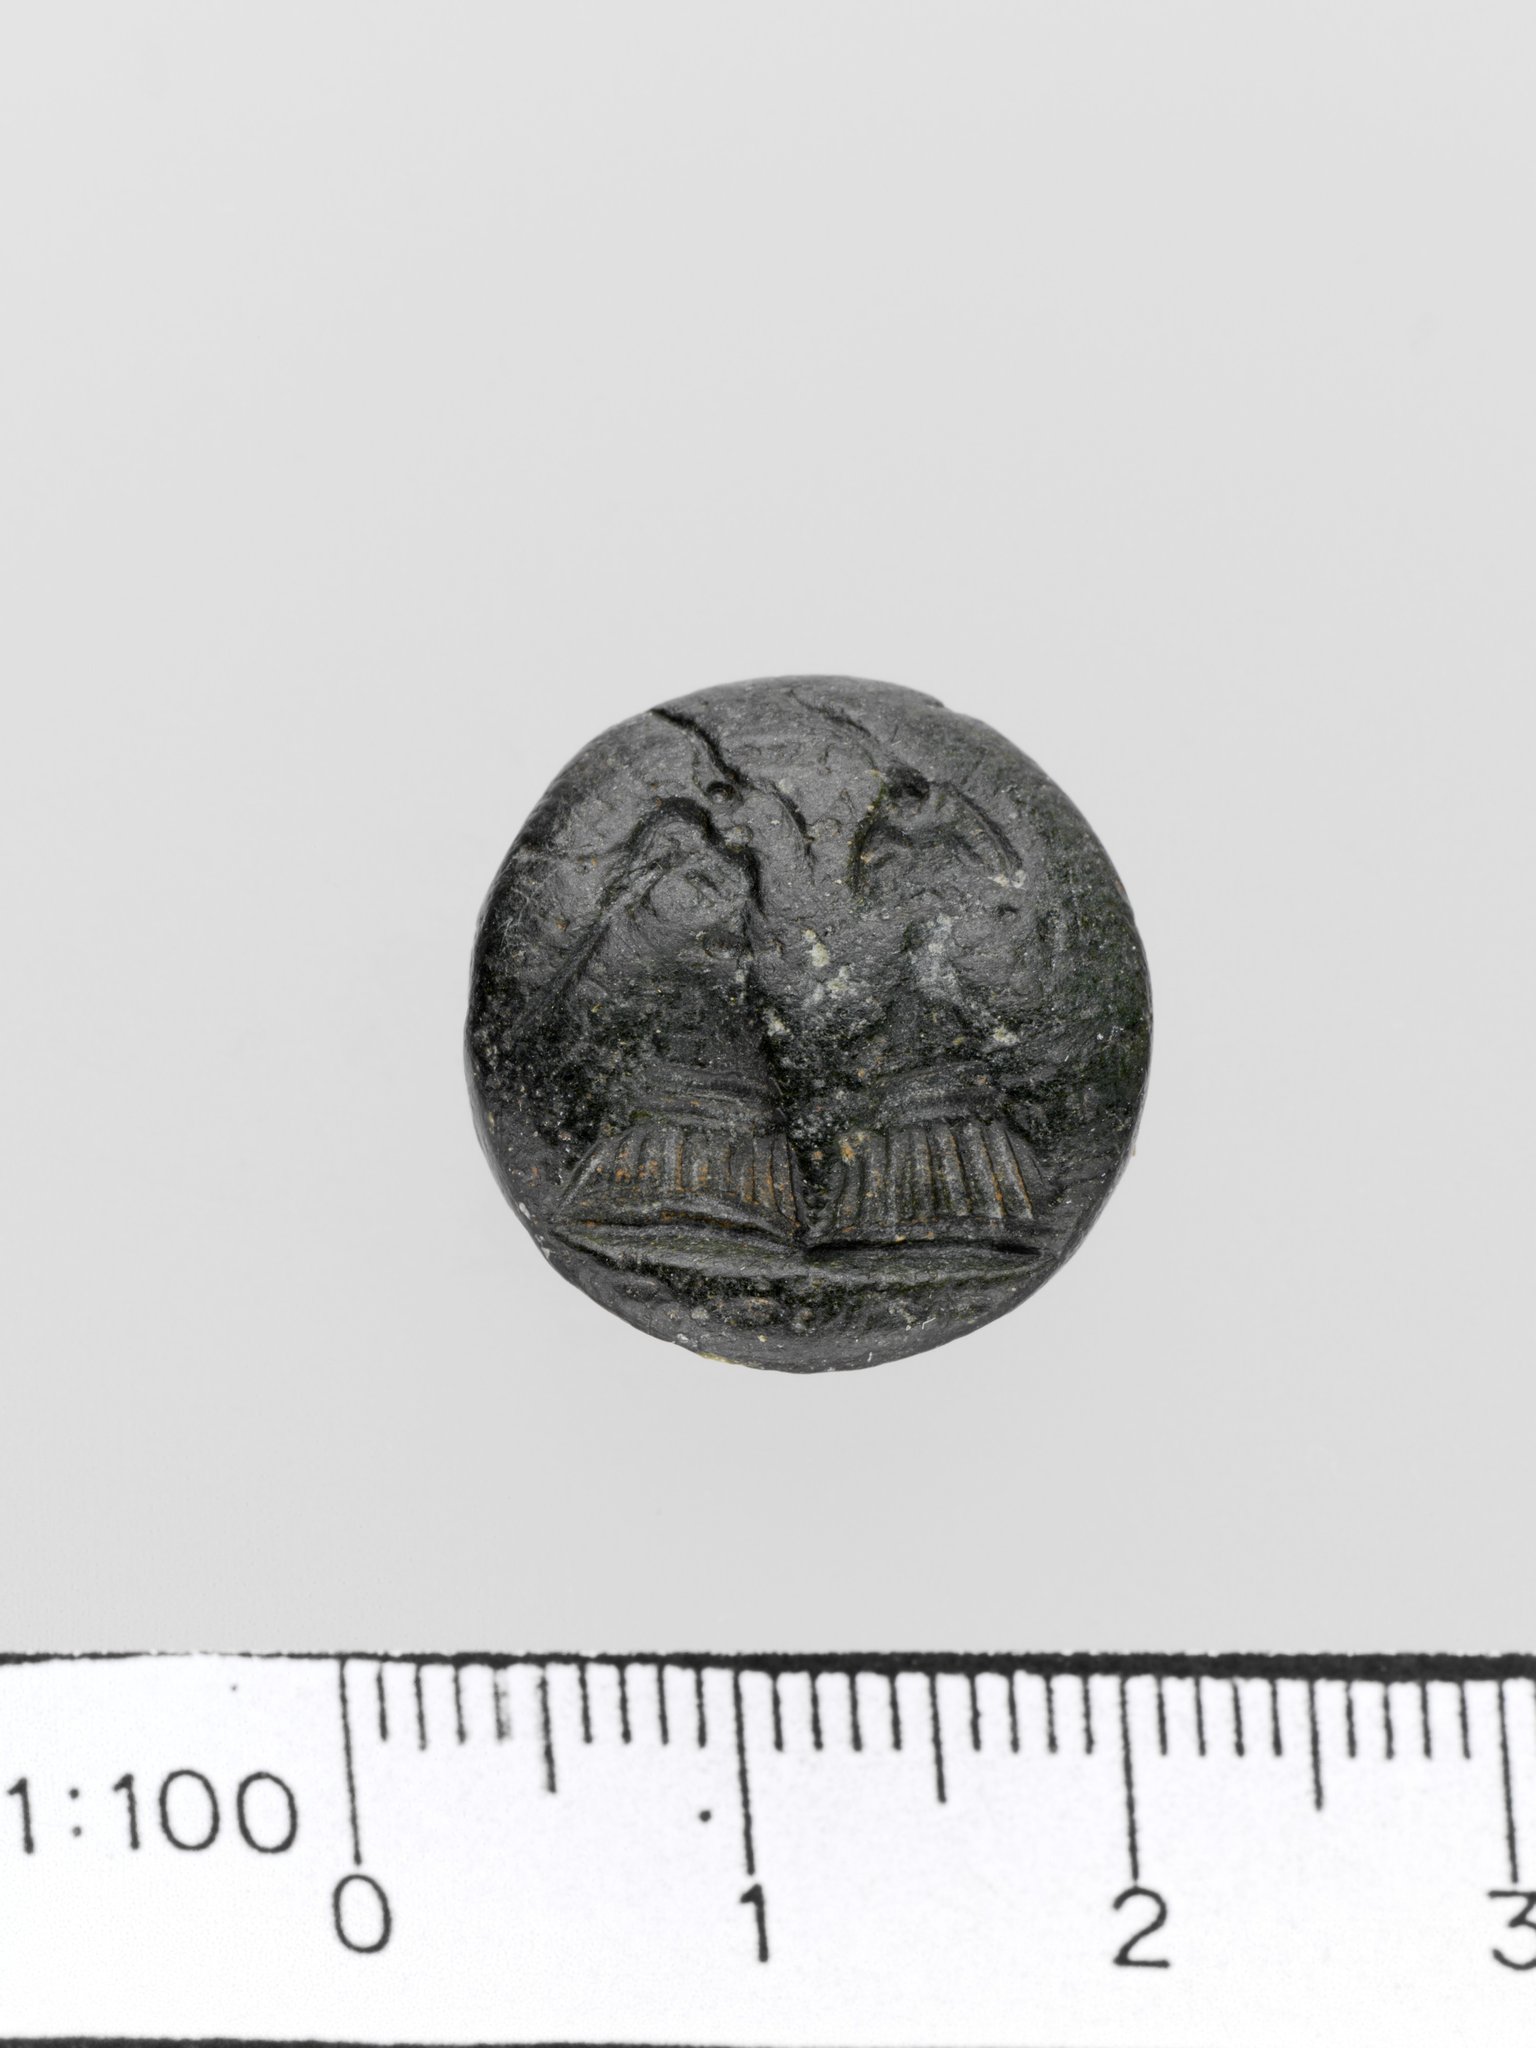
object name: seal, lentoid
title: Steatite lentoid seal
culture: minoan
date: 1400-1300 BCE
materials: stone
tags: women